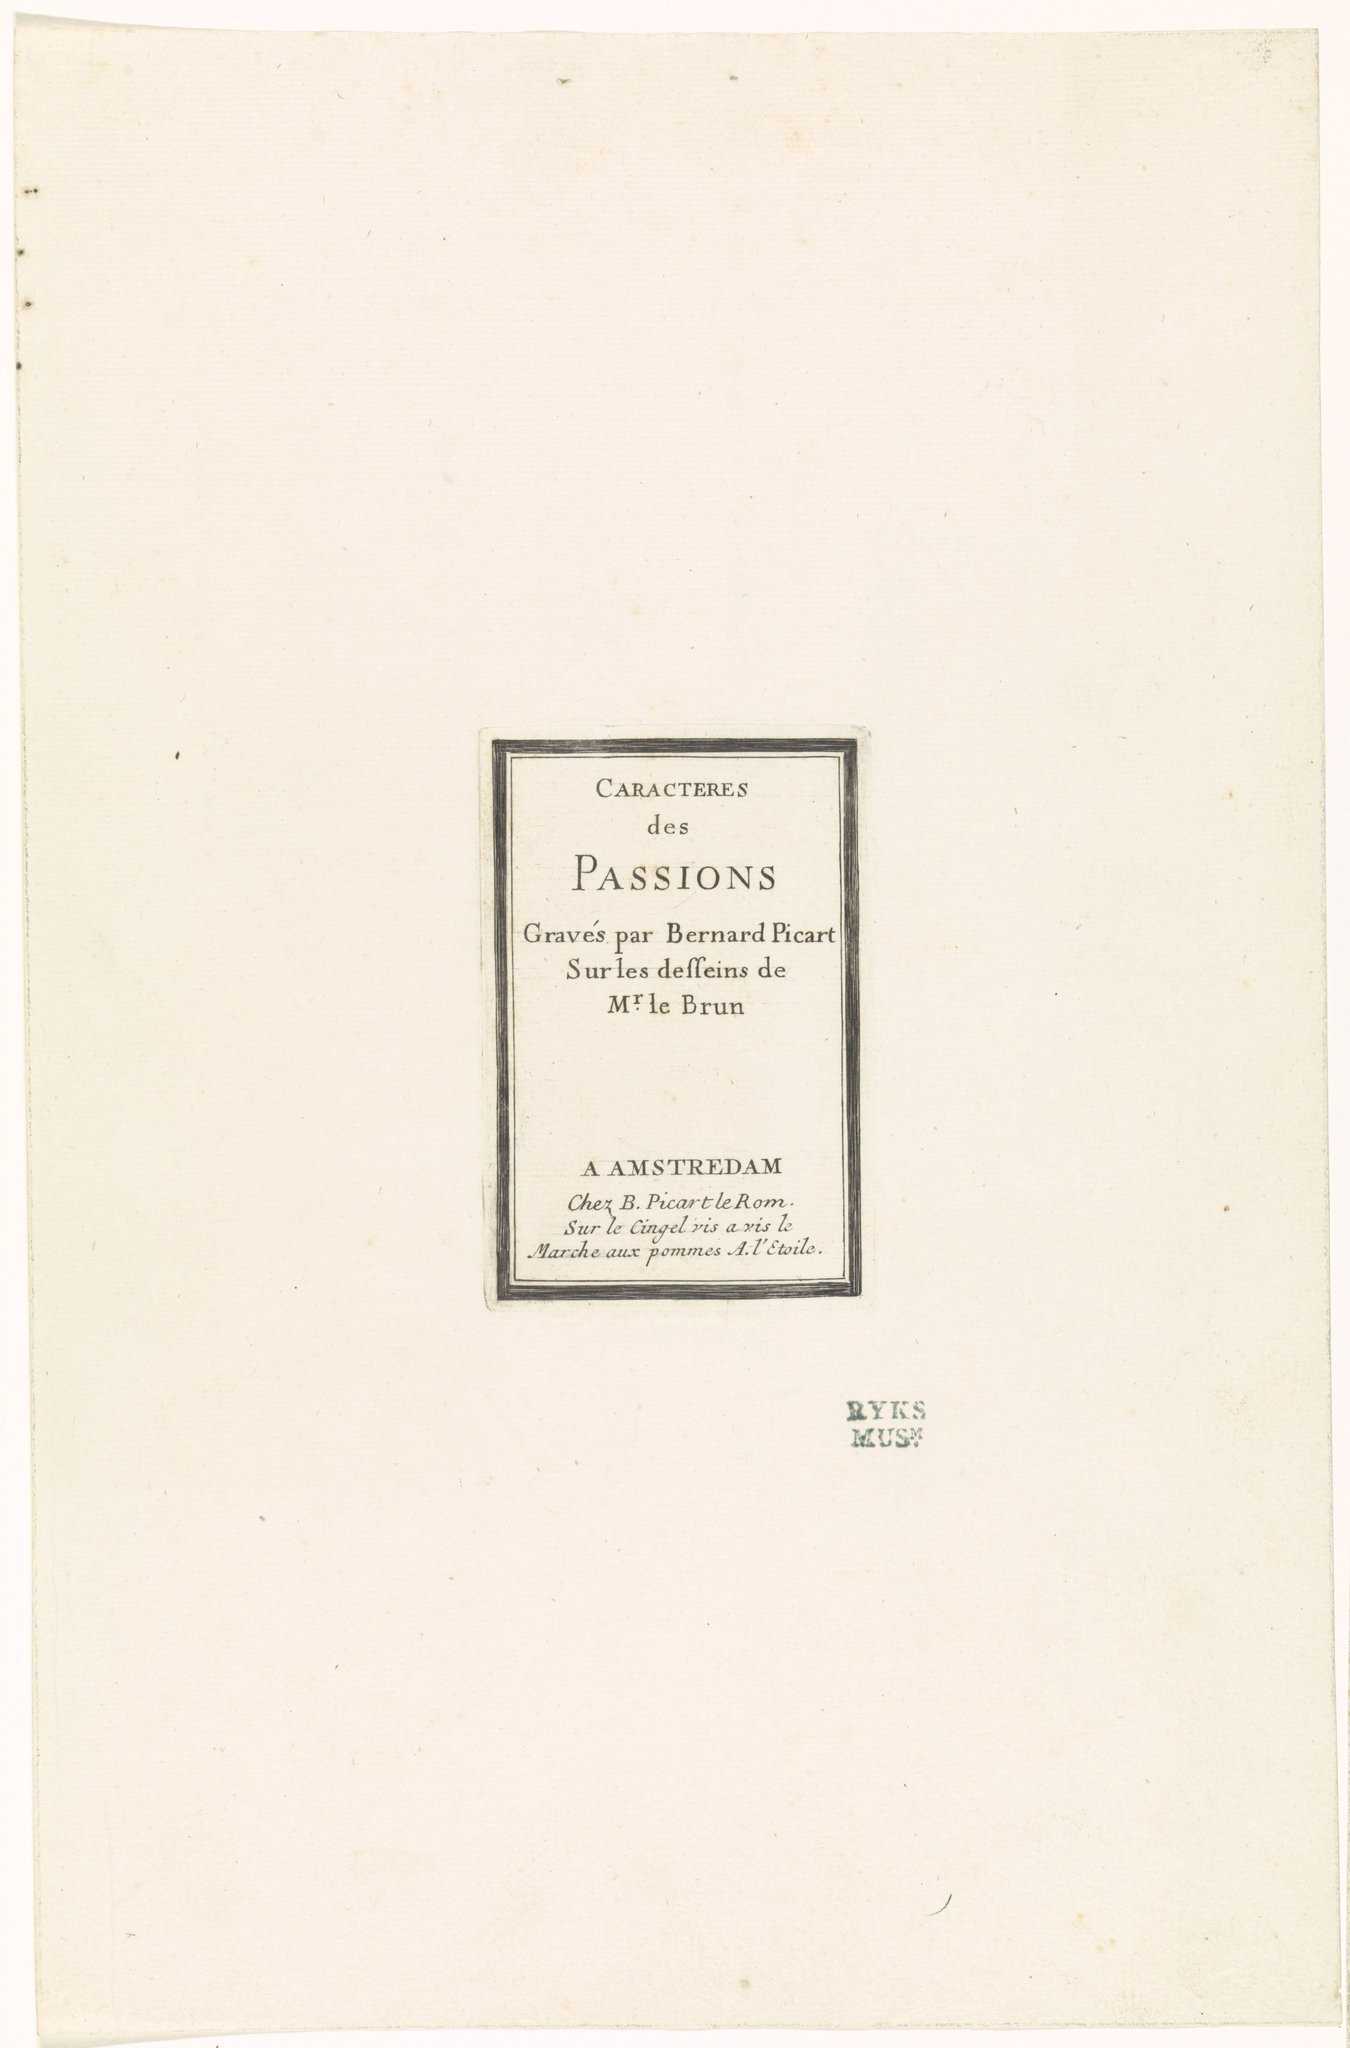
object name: titelblad, titelpagina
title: Titelpagina voor: C. Le Brun, Caracteres des Passions, 1711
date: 1711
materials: paper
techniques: engraving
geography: amsterdam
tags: title-page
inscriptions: collector's mark: Lugt 2165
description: Titelpagina voor: Le Brun, Charles. Conference de monsieur Le Brun premier peintre du roi de France (...) sur l'expression generale & particuliere des passions. Amsterdam: Bernard Picart, 1711.